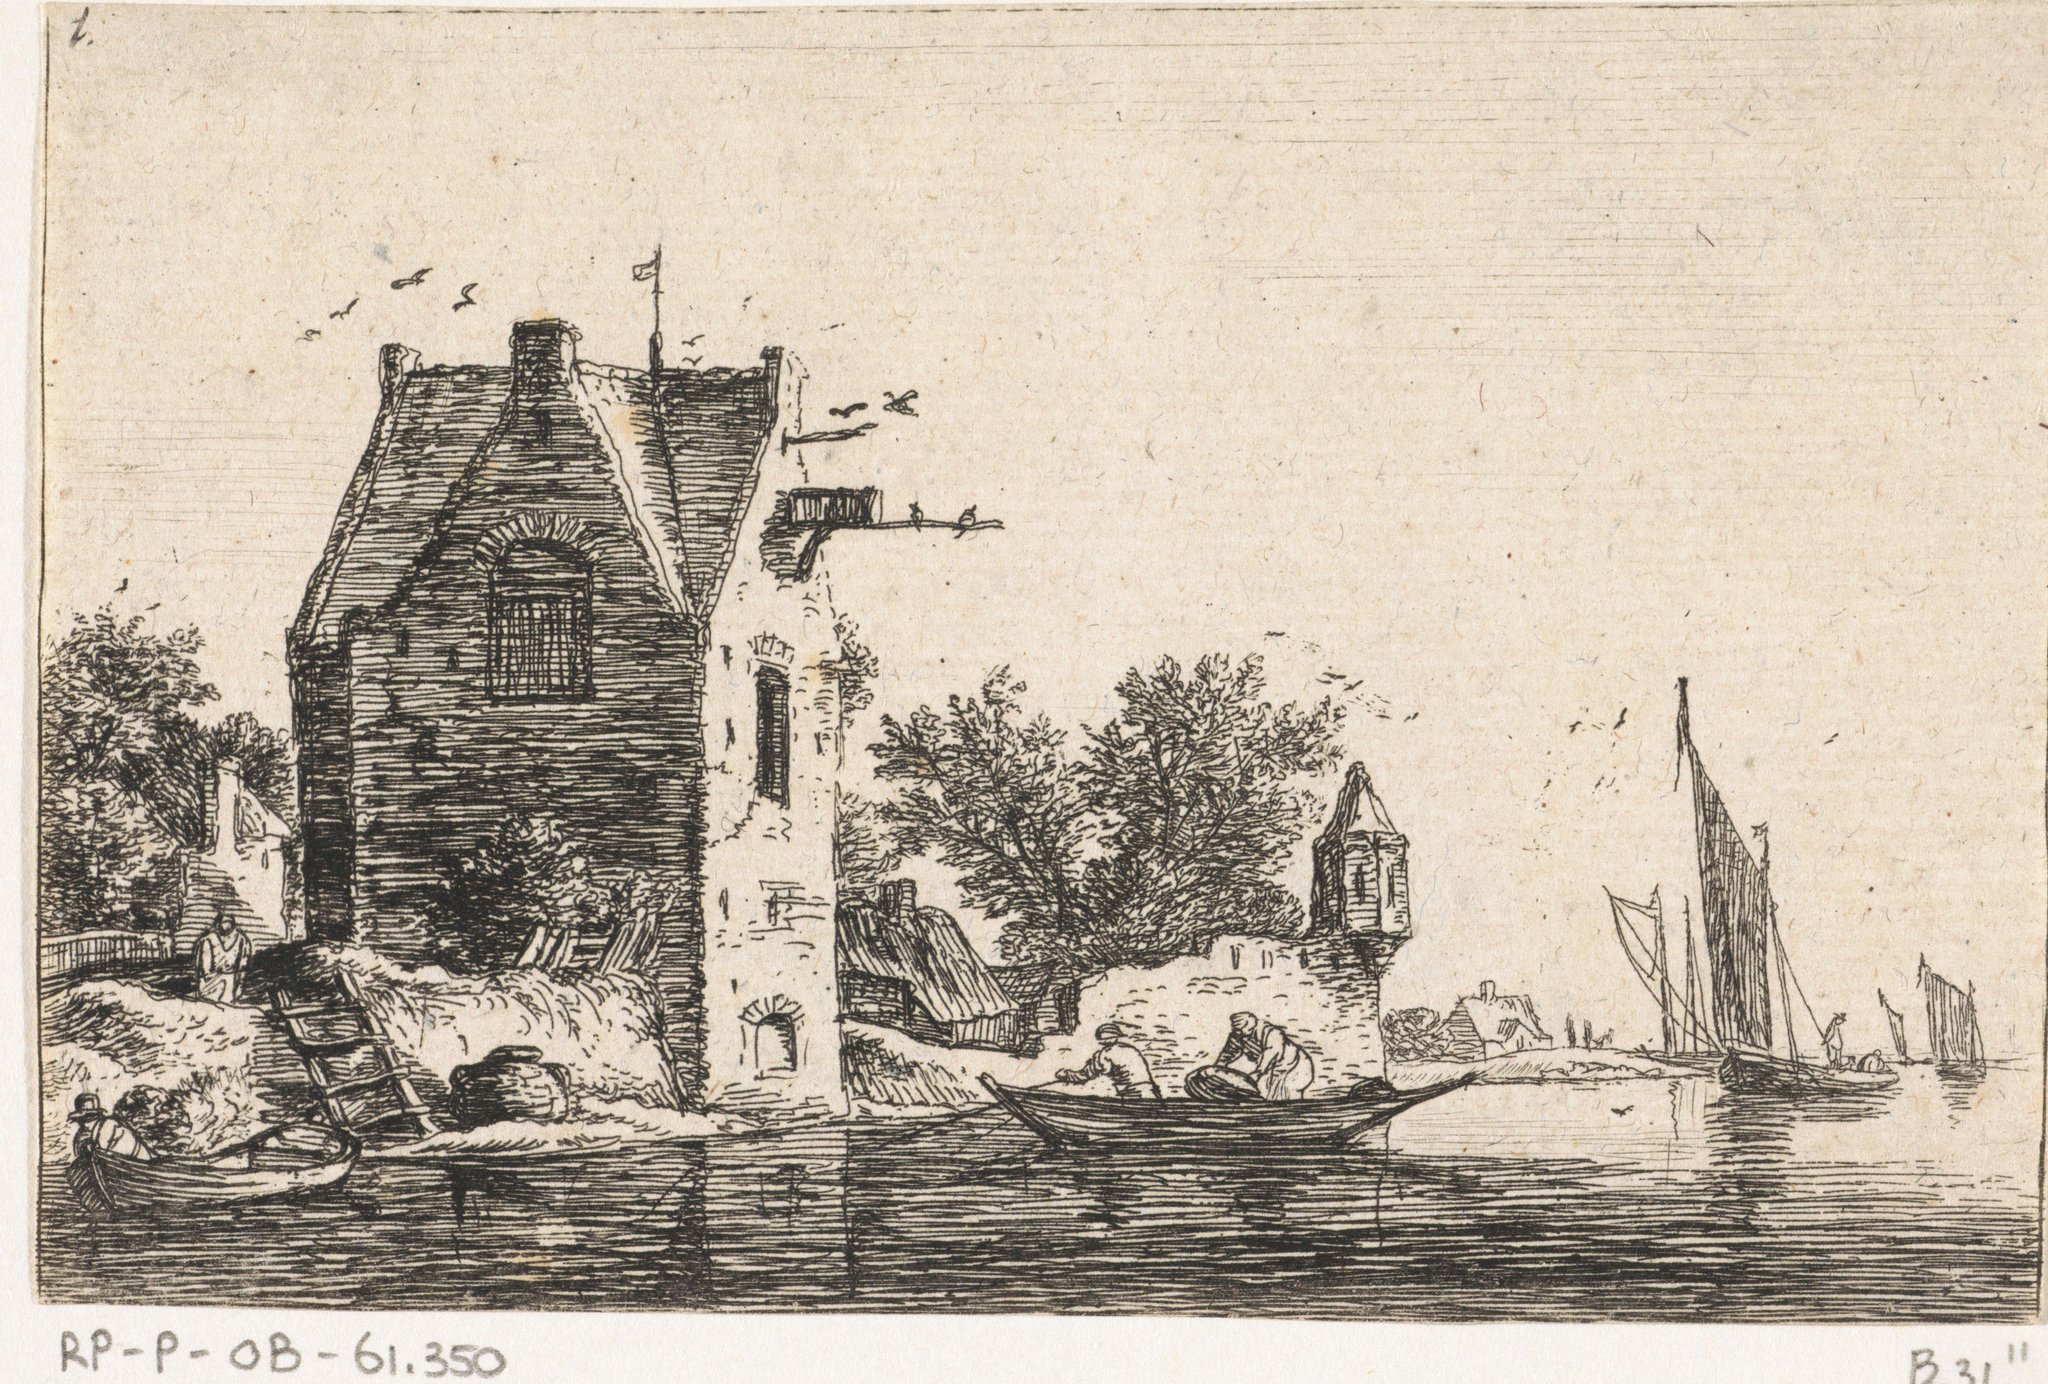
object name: print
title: Hoog gebouw aan het water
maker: anthonie waterloo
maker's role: draughtsman, painter, print maker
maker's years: 1609-1690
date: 1630-1663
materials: paper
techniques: etching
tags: sentry box, sailing-ship, sailing-boat, landscapes with waters, waterscapes, seascapes (in the temperate zone), rowing-boat, canoe, etc., city-walls, landscapes (+ landscape with figures, staffage)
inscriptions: collector's mark: Lugt 2228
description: Een hoog gebouw ligt aan het water. Rechts van het gebouw ligt een deel van de stadsmuur met een wachthuisje. In het water boten. Linksboven is de letter l te zien.